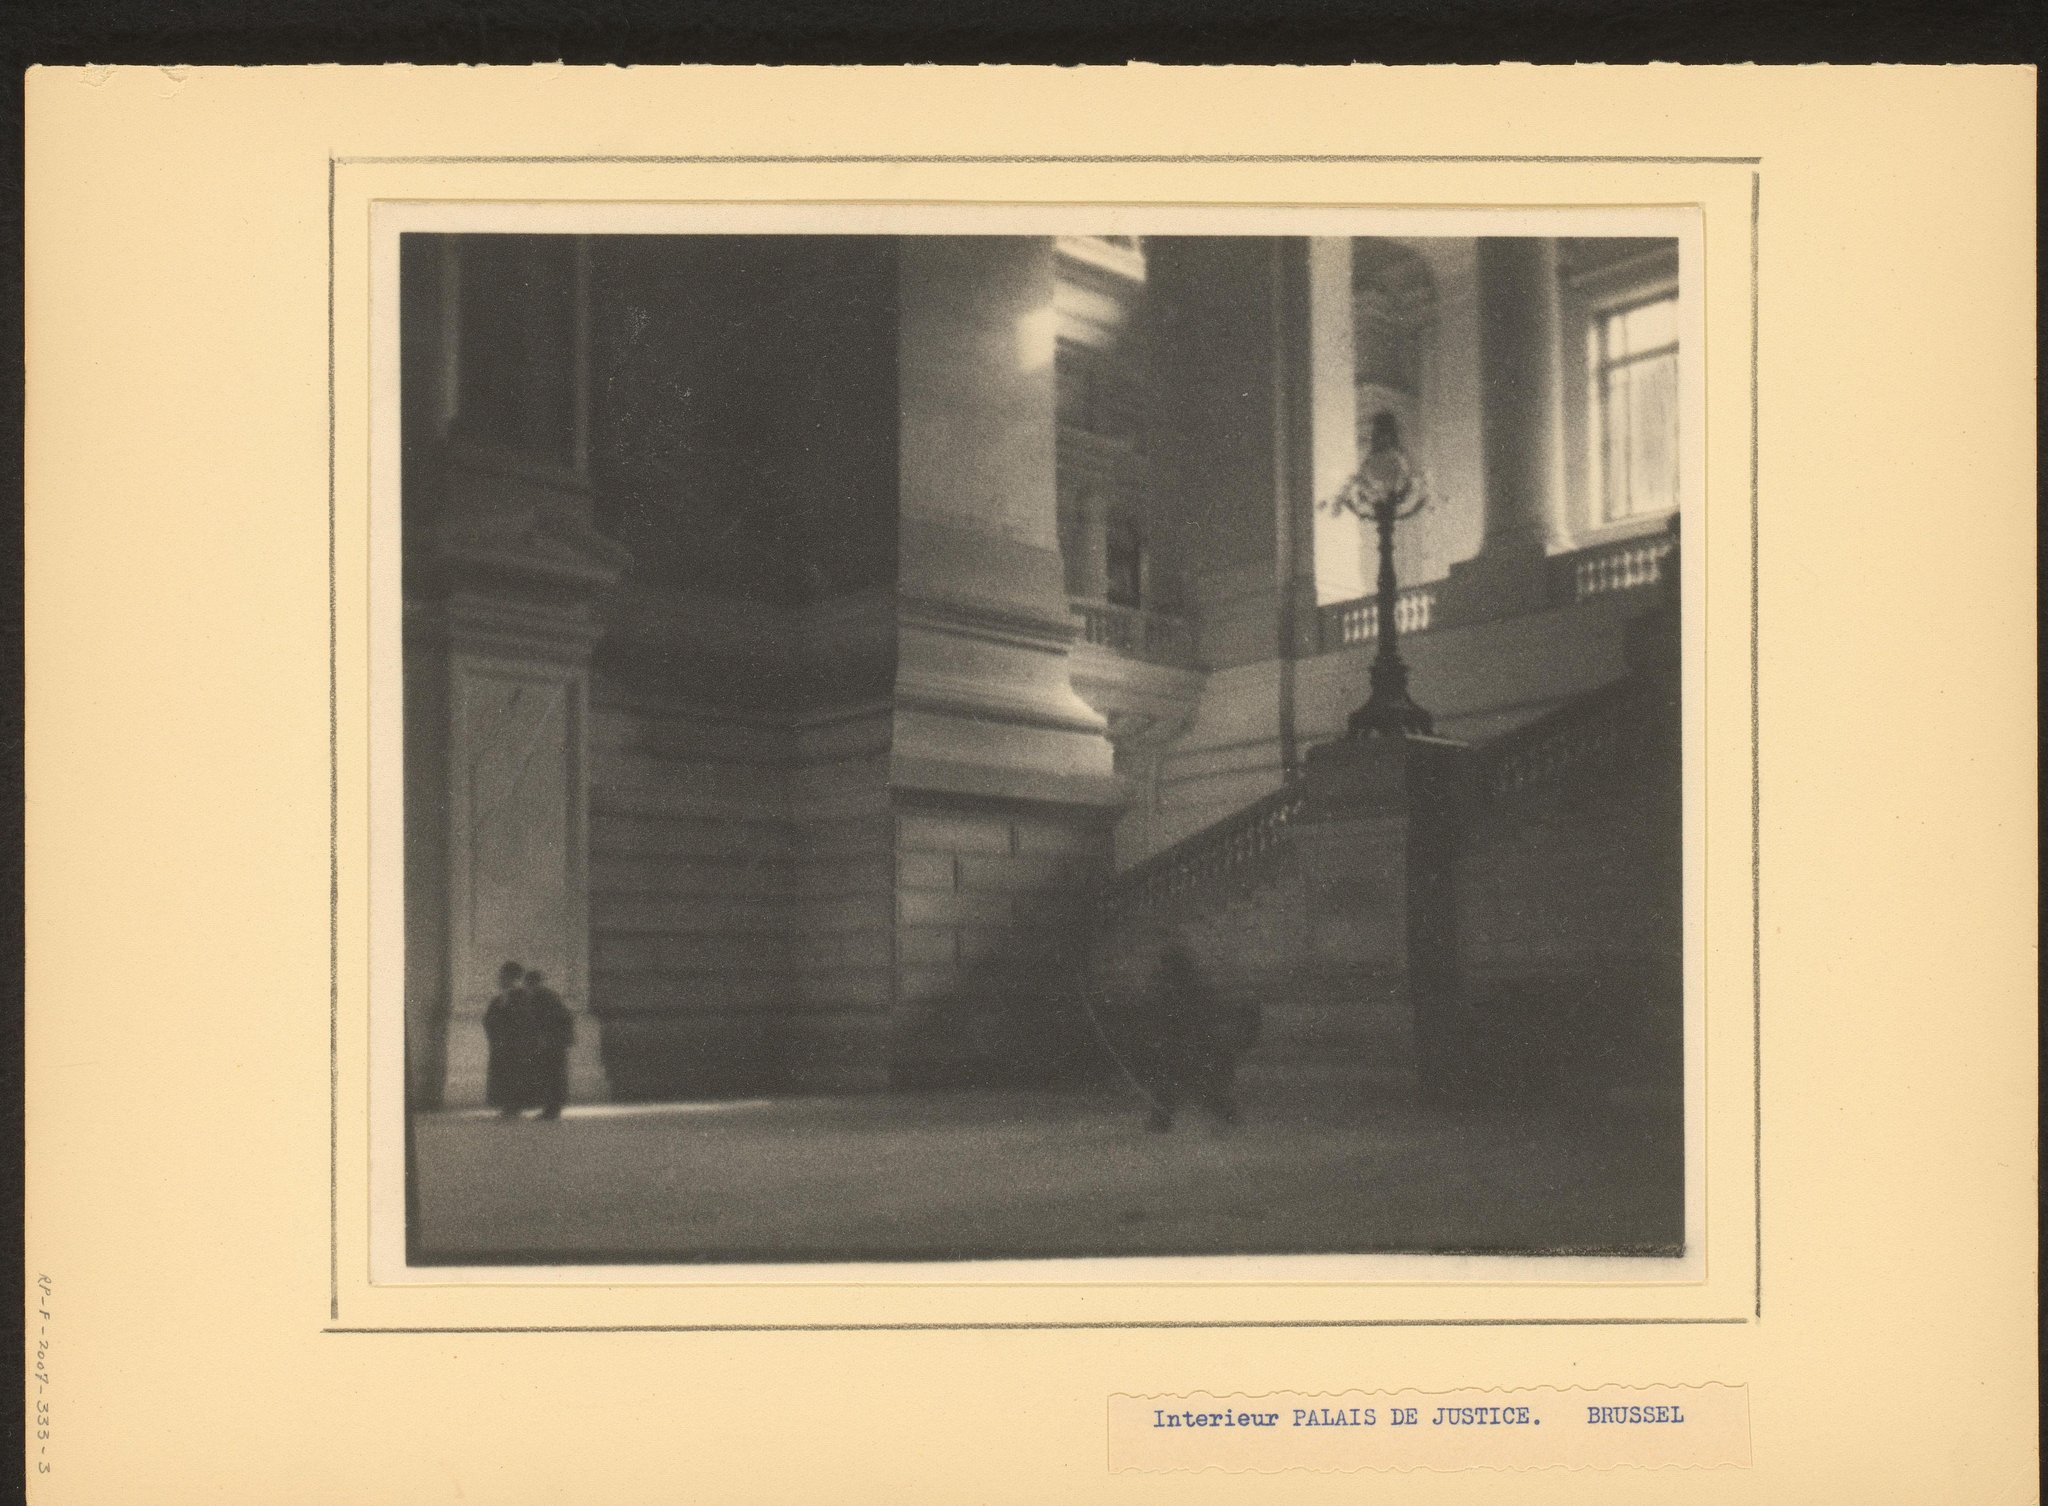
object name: photograph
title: Interieur van het Paleis van Justitie, Brussel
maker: gerrit elink schuurman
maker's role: fotograaf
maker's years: 1876-1953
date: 1935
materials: paper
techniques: gelatin silver print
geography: brussels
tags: court building, corridor